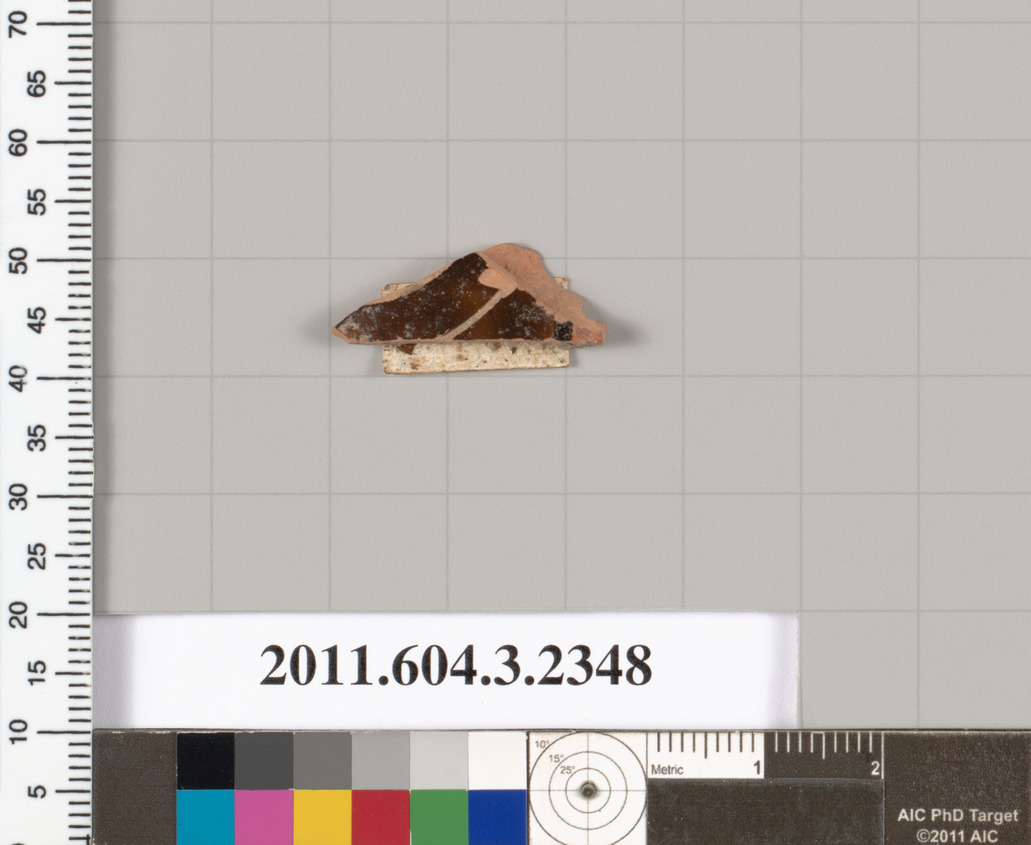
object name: kylix fragment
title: Terracotta fragment of a kylix: eye-cup (drinking cup)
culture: greek, attic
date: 540-520 BCE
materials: terracotta